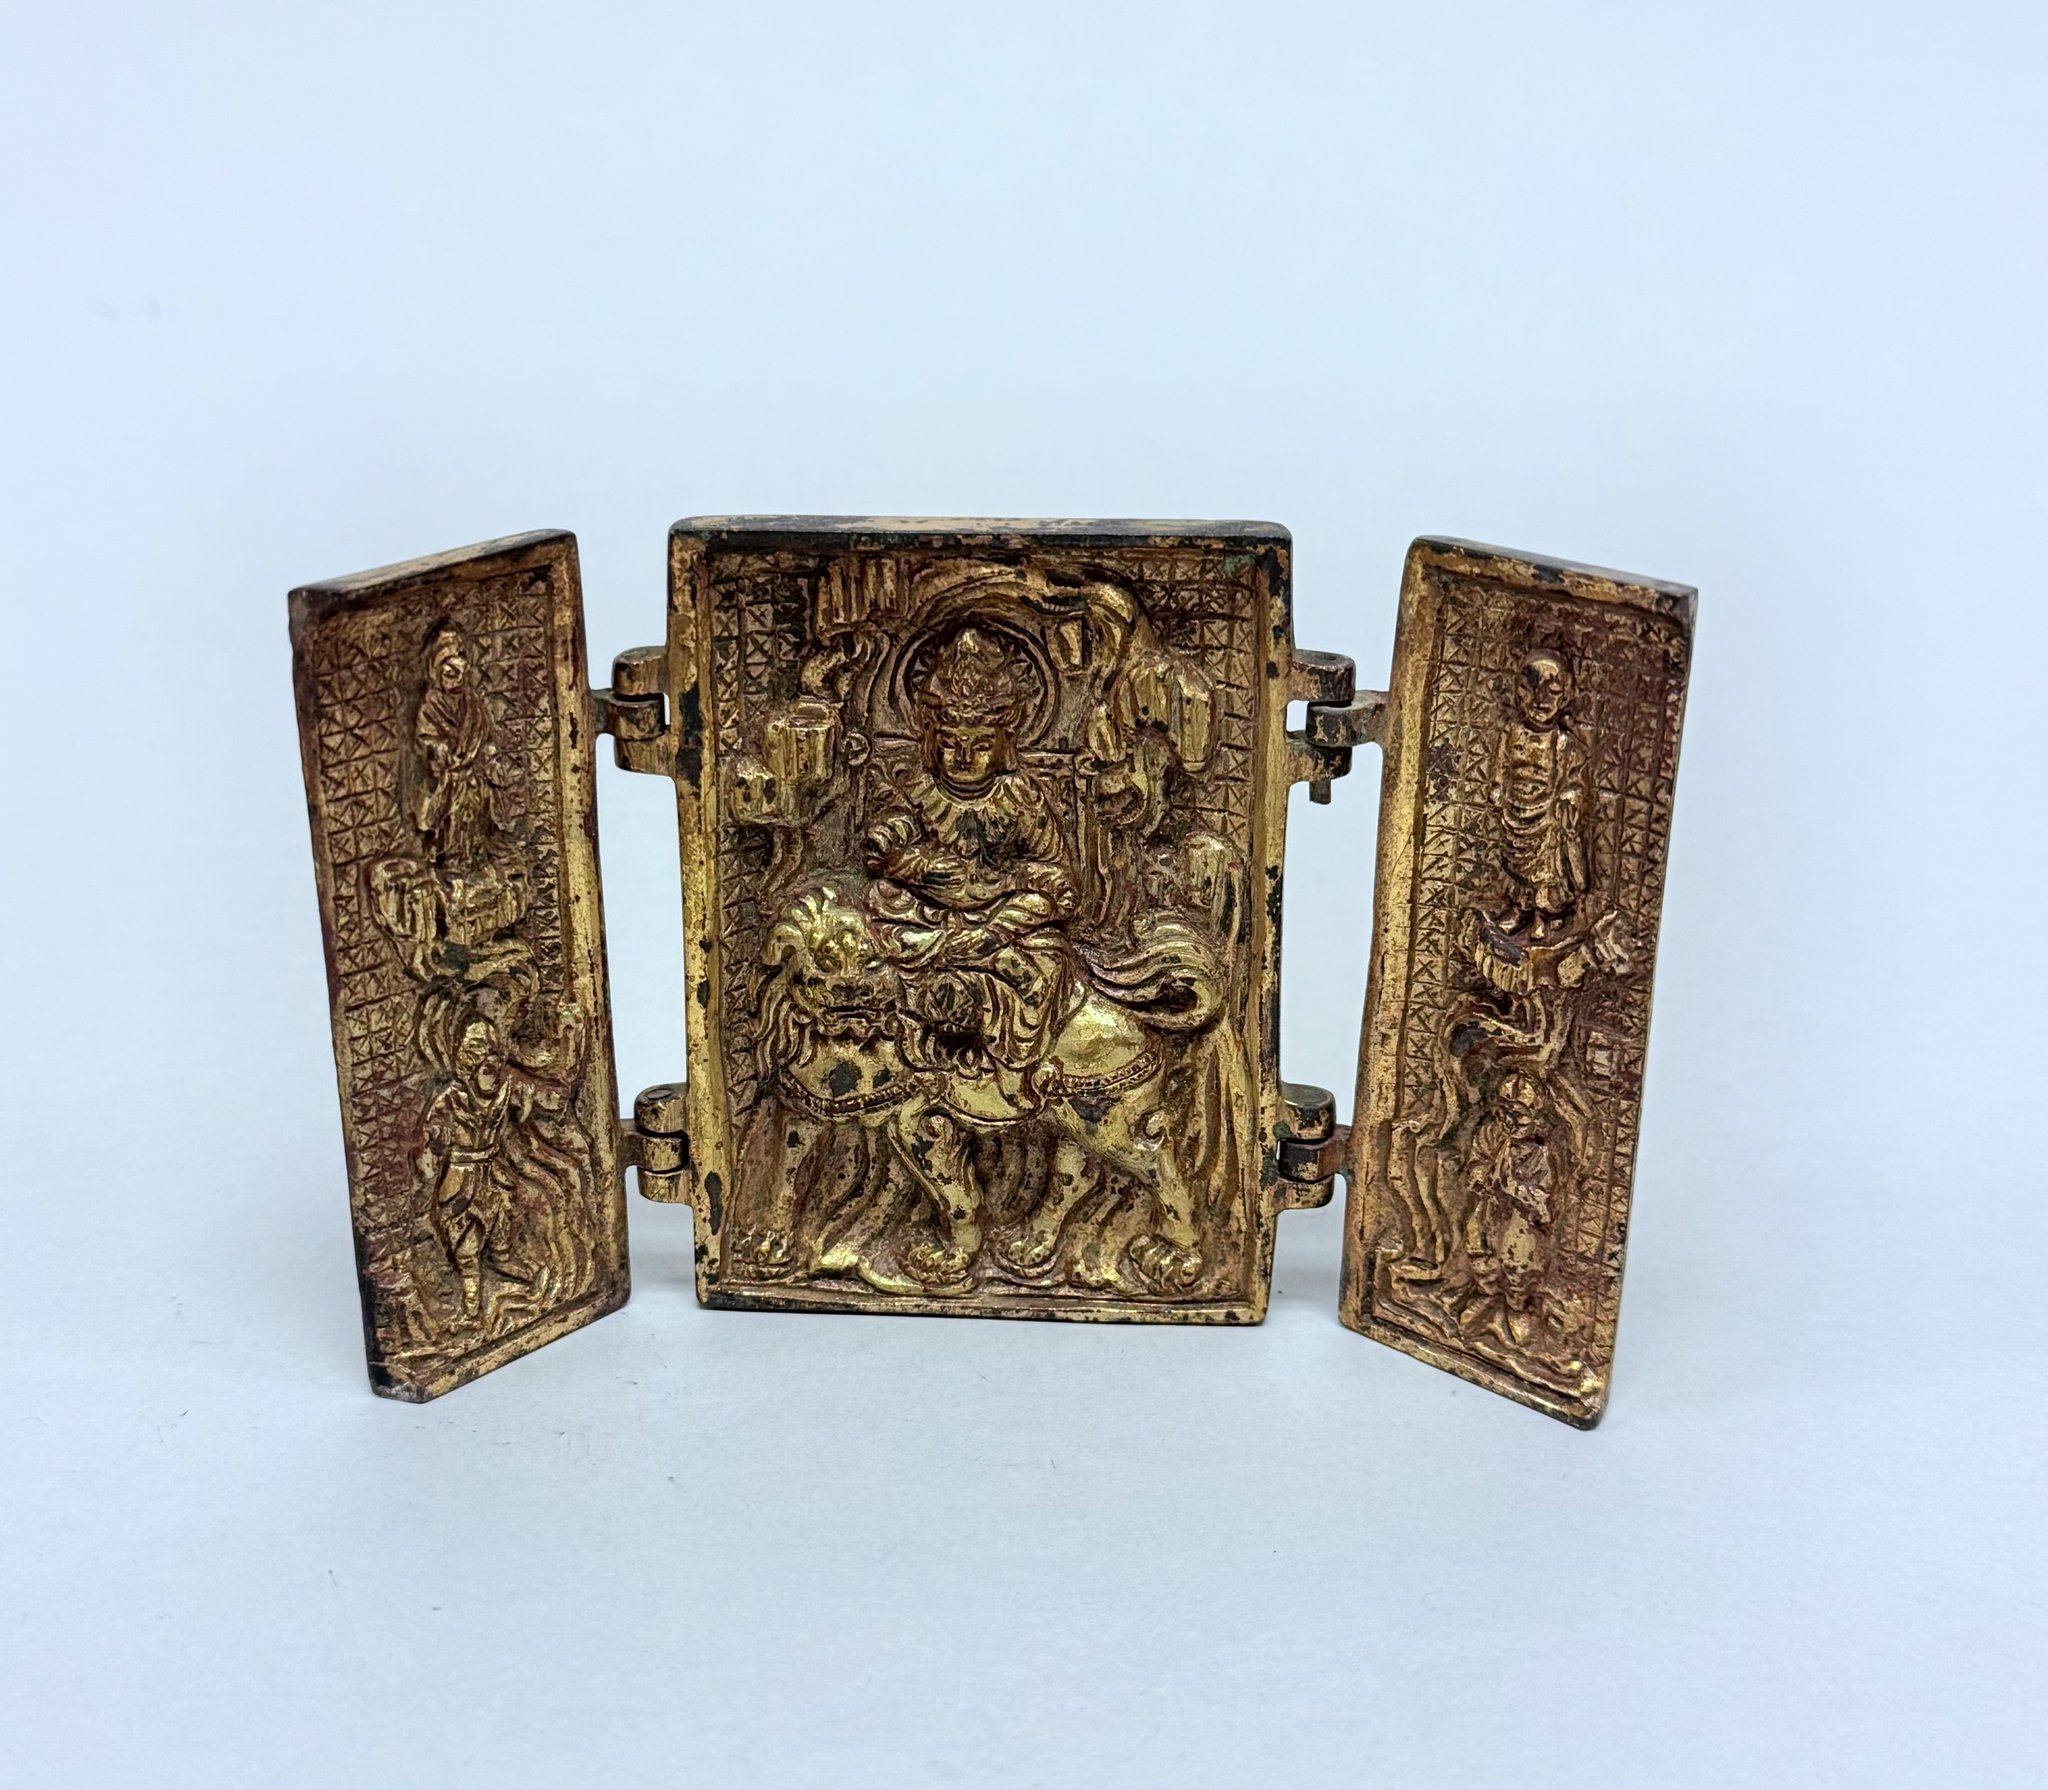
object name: portable altar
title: Portable altarpiece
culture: japanese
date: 1185-1333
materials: bronze, gilt